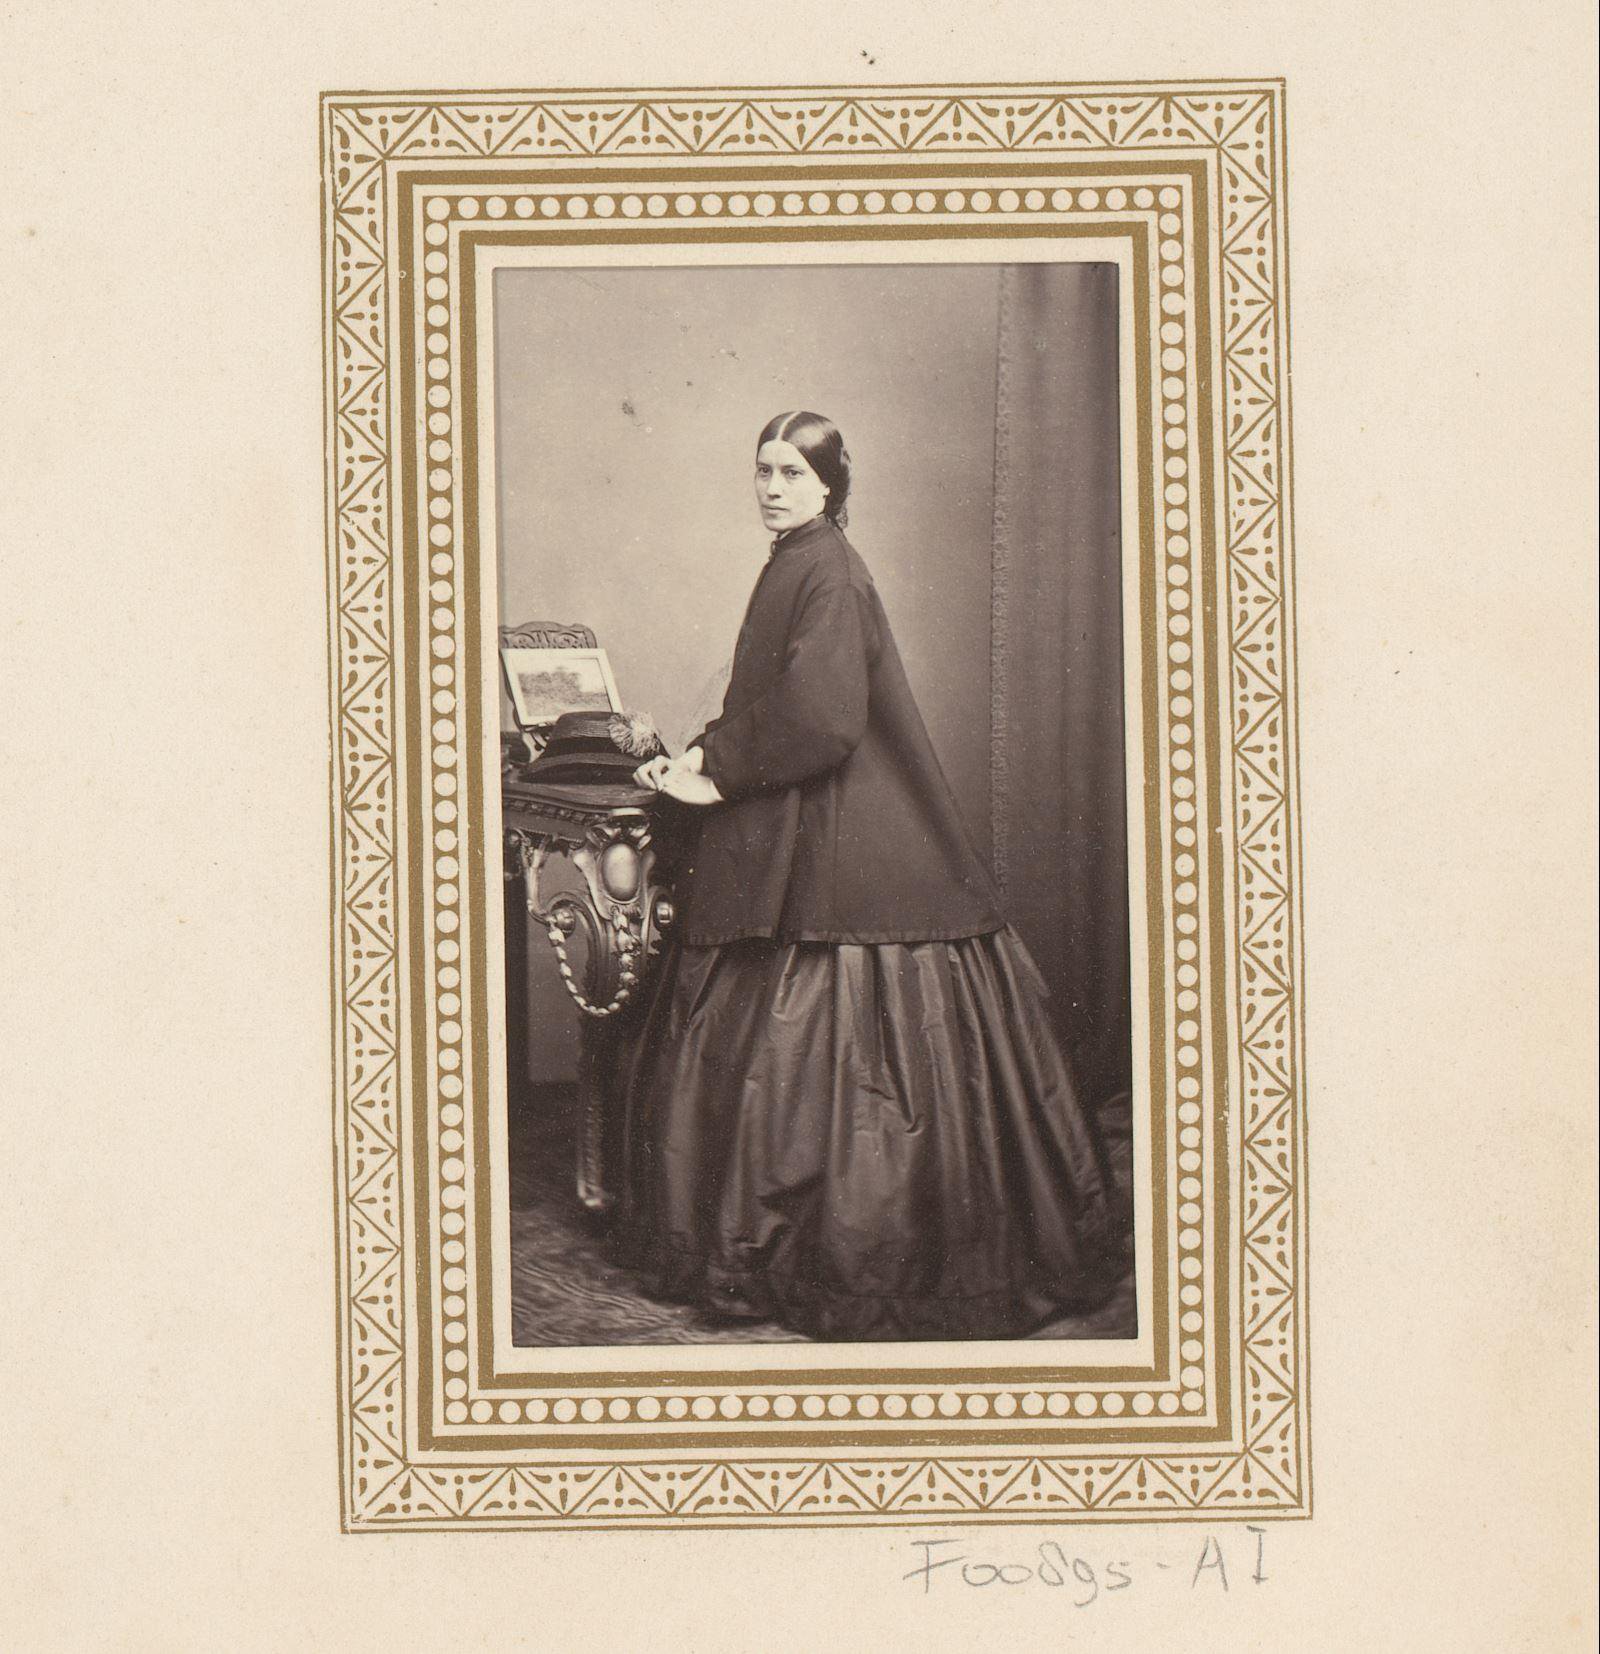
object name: photograph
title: Portret een staande vrouw bij een tafel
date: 1867-1875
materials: cardboard, photographic support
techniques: albumen print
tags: historical persons, standing figure - aa - female human figure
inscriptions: inscription: ‘G & R Lavis/ Photographers &/ Miniature Painters/ 135, Regent St/ W.’